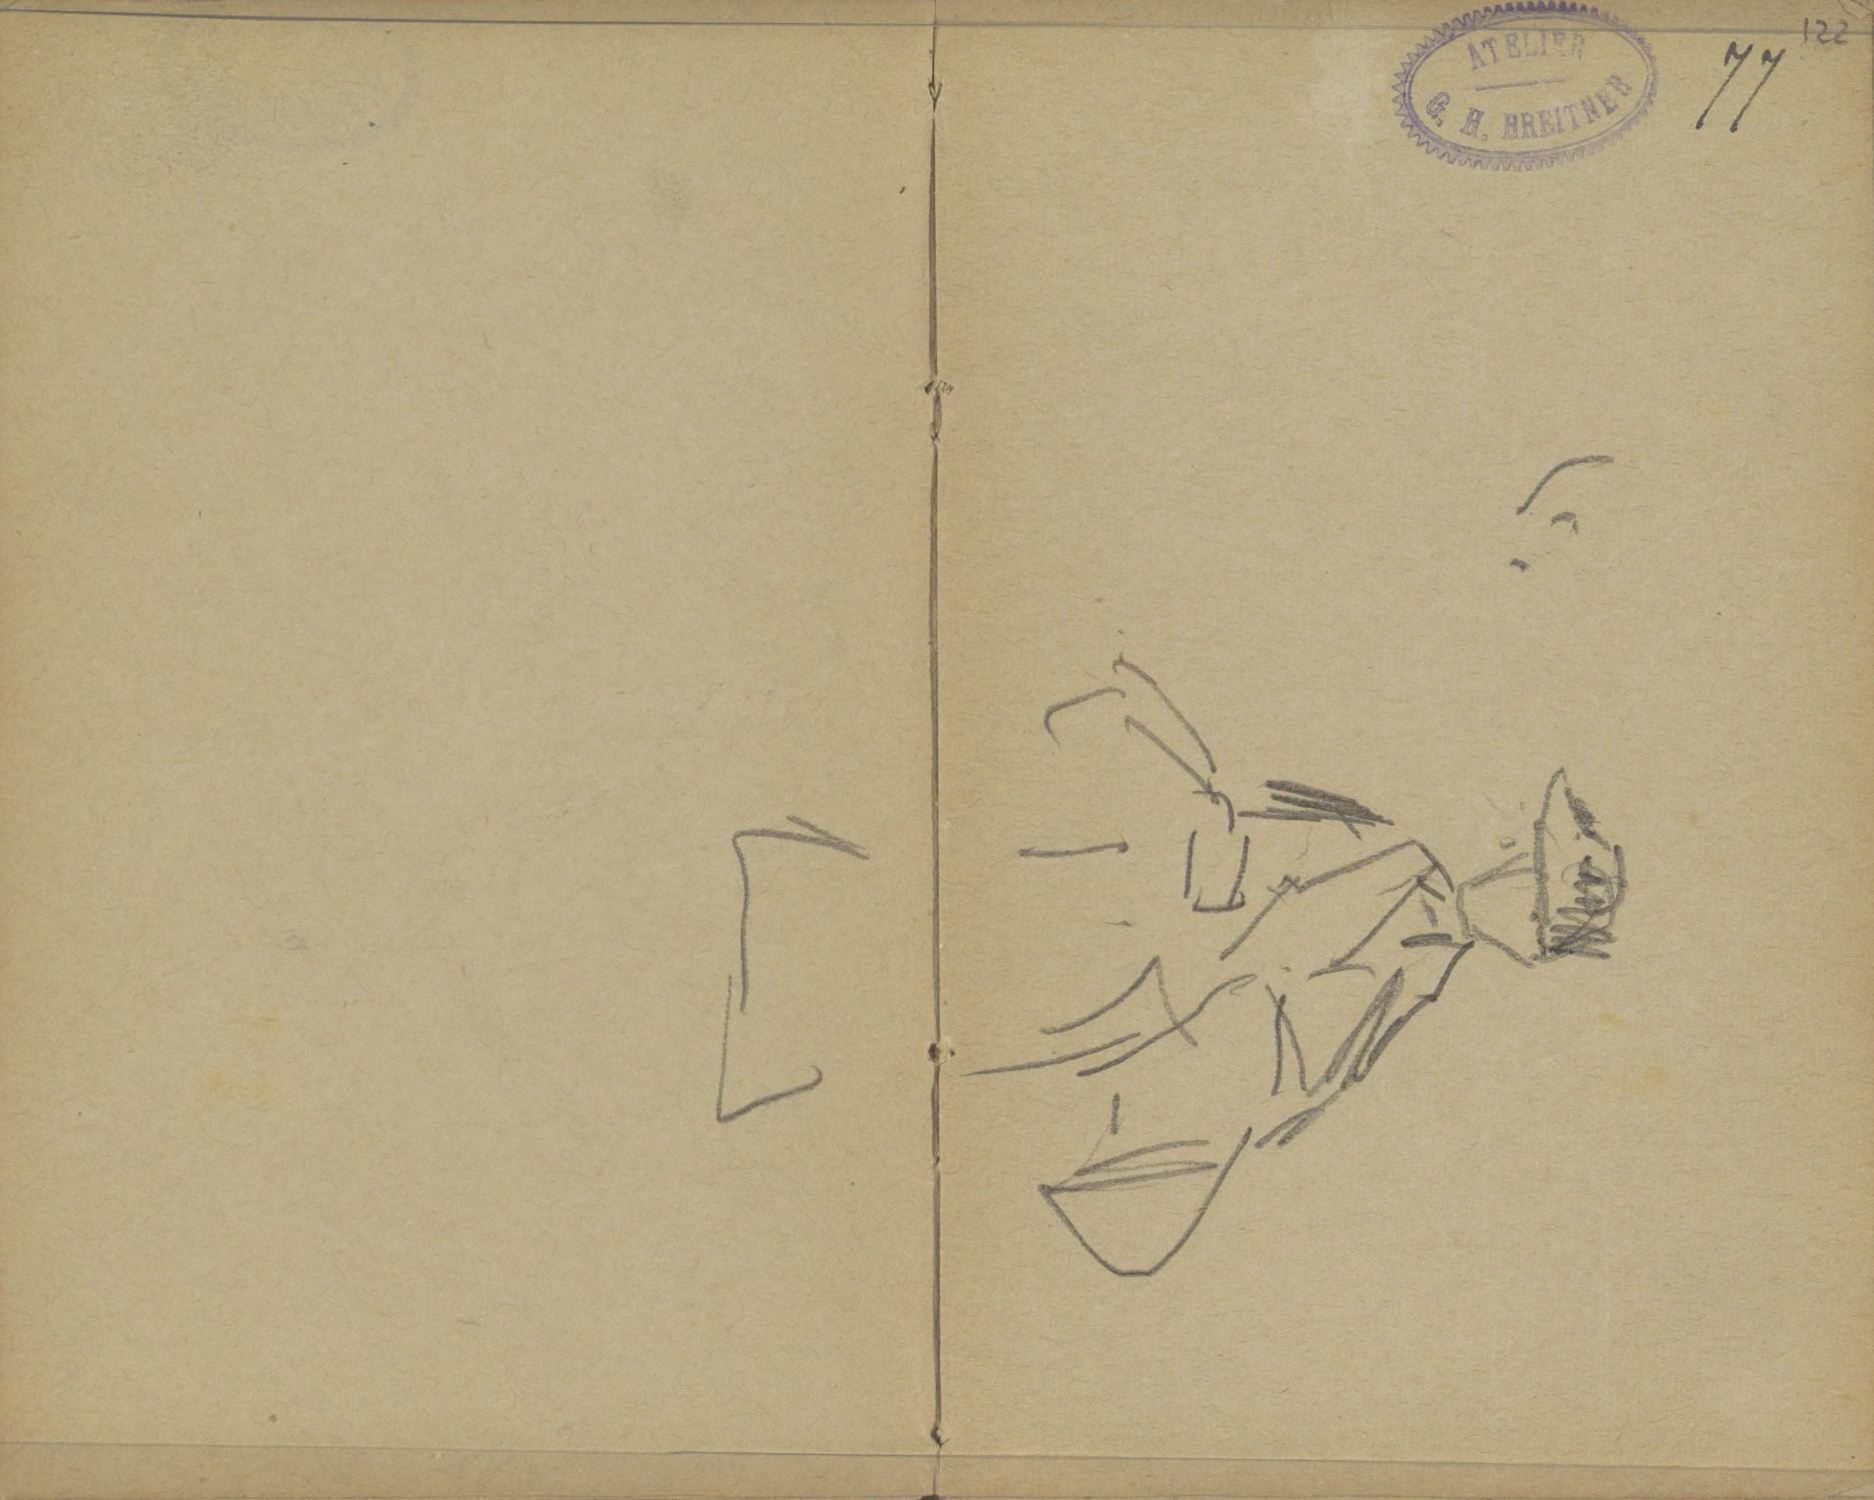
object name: sketchbook leaf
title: Vrouw met hoed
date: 1887-1891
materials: paper, pencil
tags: adult woman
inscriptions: workshop stamp: Lugt 291d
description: Pagina 121 en pagina 122 uit een schetsboek met 83 bladen.